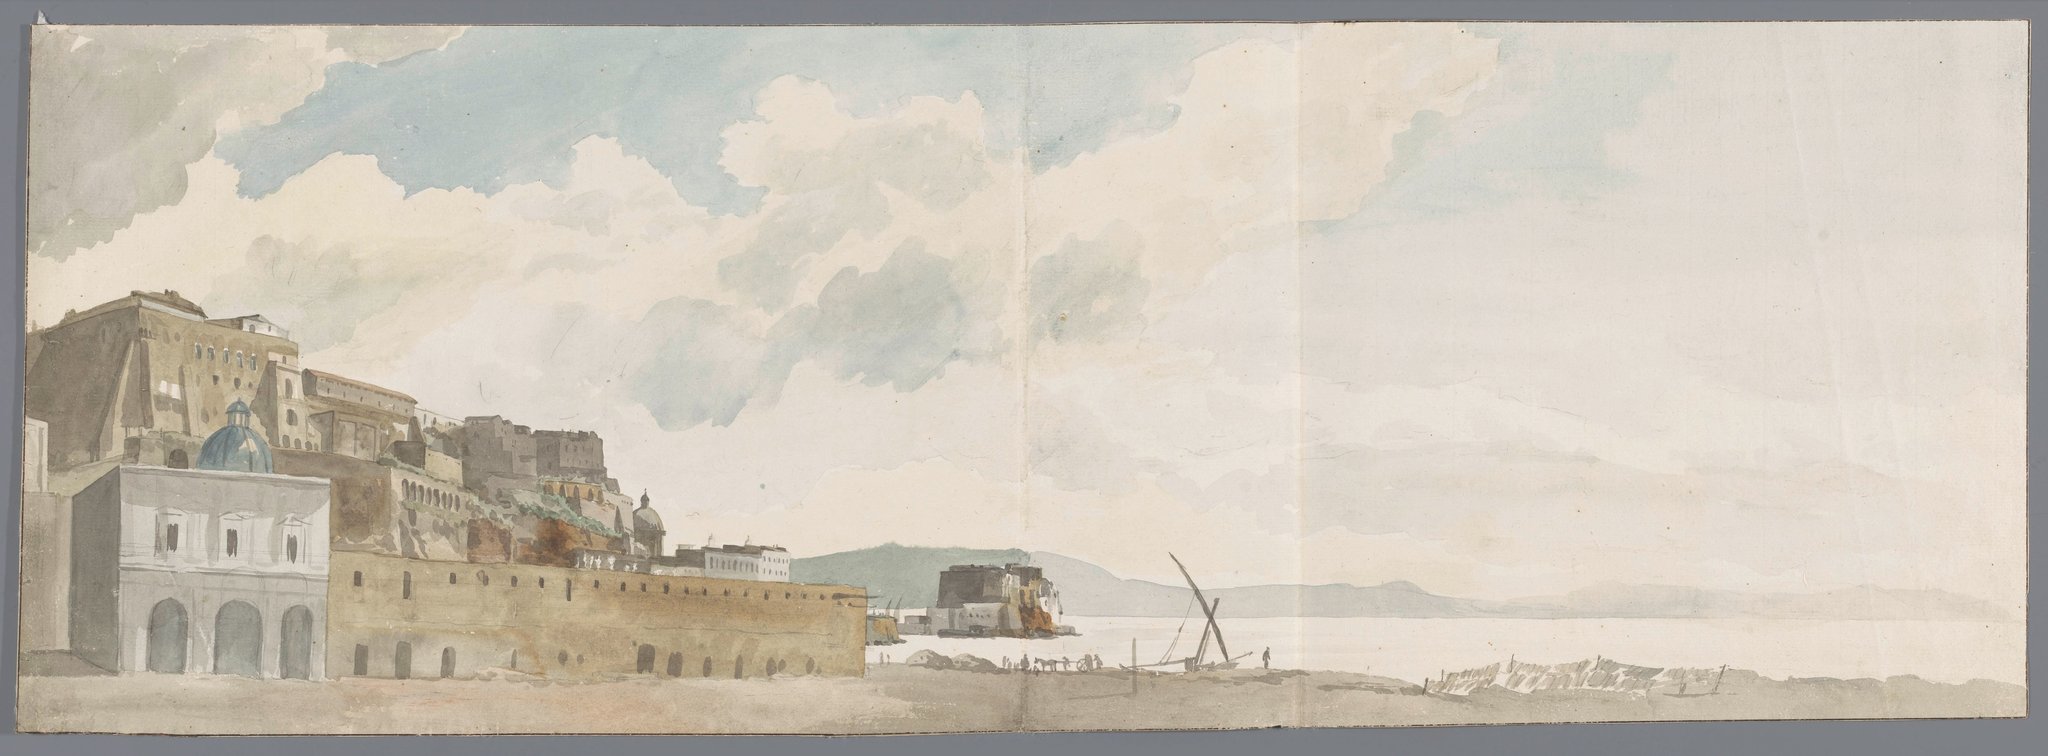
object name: watercolor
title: Voyage en Italie, en Sicile et à Malte - 1778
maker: louis ducros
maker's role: draughtsman, print maker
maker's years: 1748-1810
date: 1778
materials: chalk, paper, watercolor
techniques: brush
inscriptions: number: ‘No 20 Vue prise du balcon de notre auberge à Naples, où se trouvent le château de l'Oeuf, l'Eglise de la Victoire, &c’